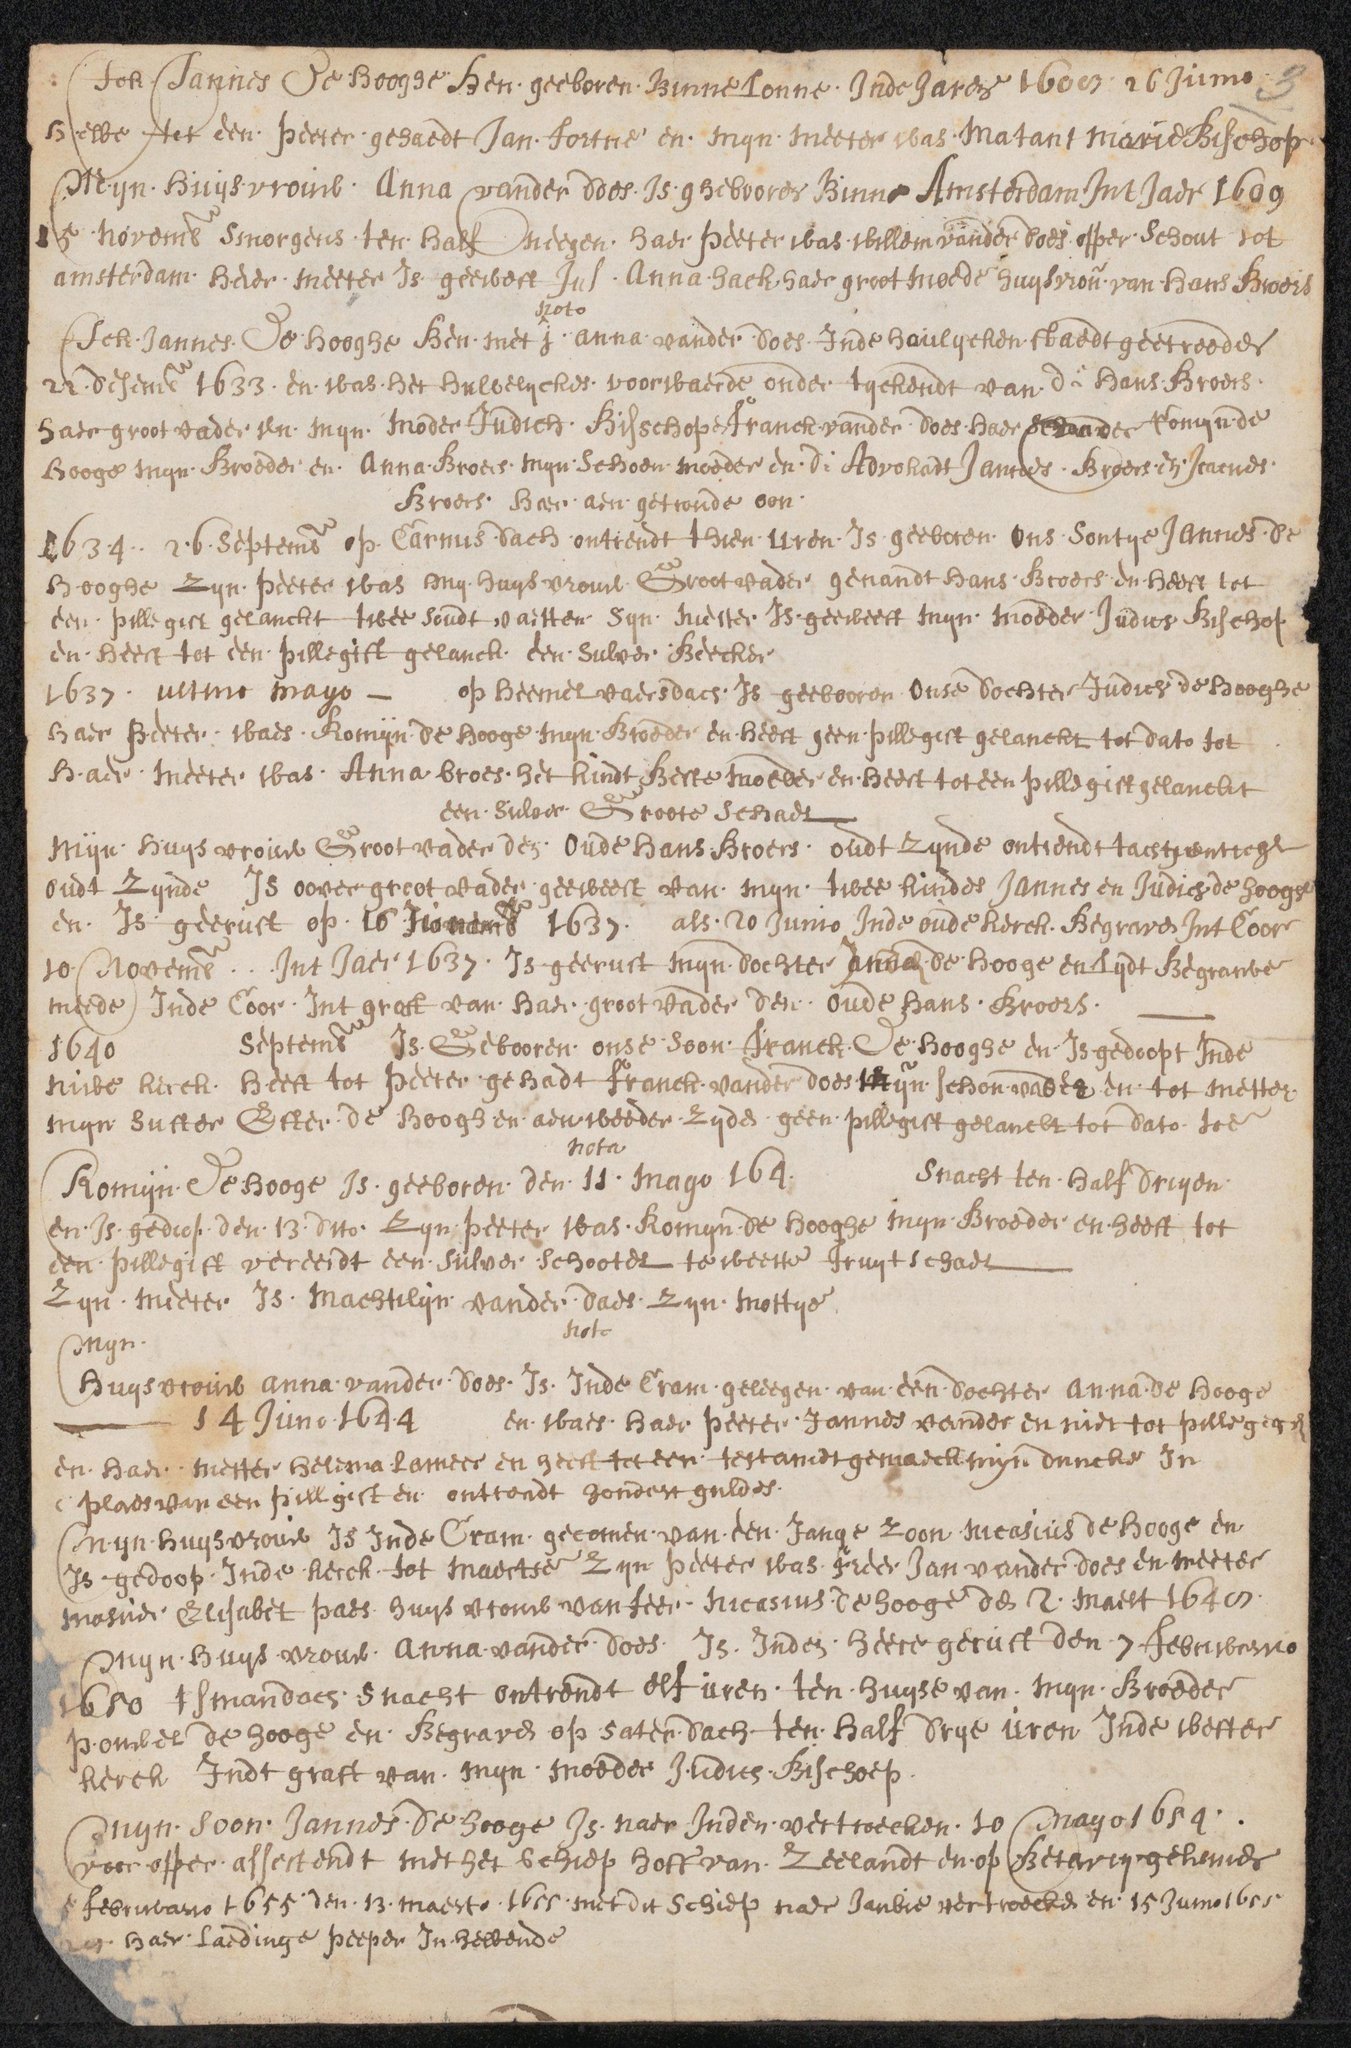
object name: manuscript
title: Handschrift betreffende Romeyn de Hooghe en familie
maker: johannes de hooghe (1608-1682)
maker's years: 1608-1682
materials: ink, paper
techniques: pen, writing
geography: amsterdam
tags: amsterdam, haarlem, painter, print maker, draughtsman, goldsmith, romeyn de hooghe, diseases, money, batavia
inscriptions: collector's mark: Lugt 2233, watermark